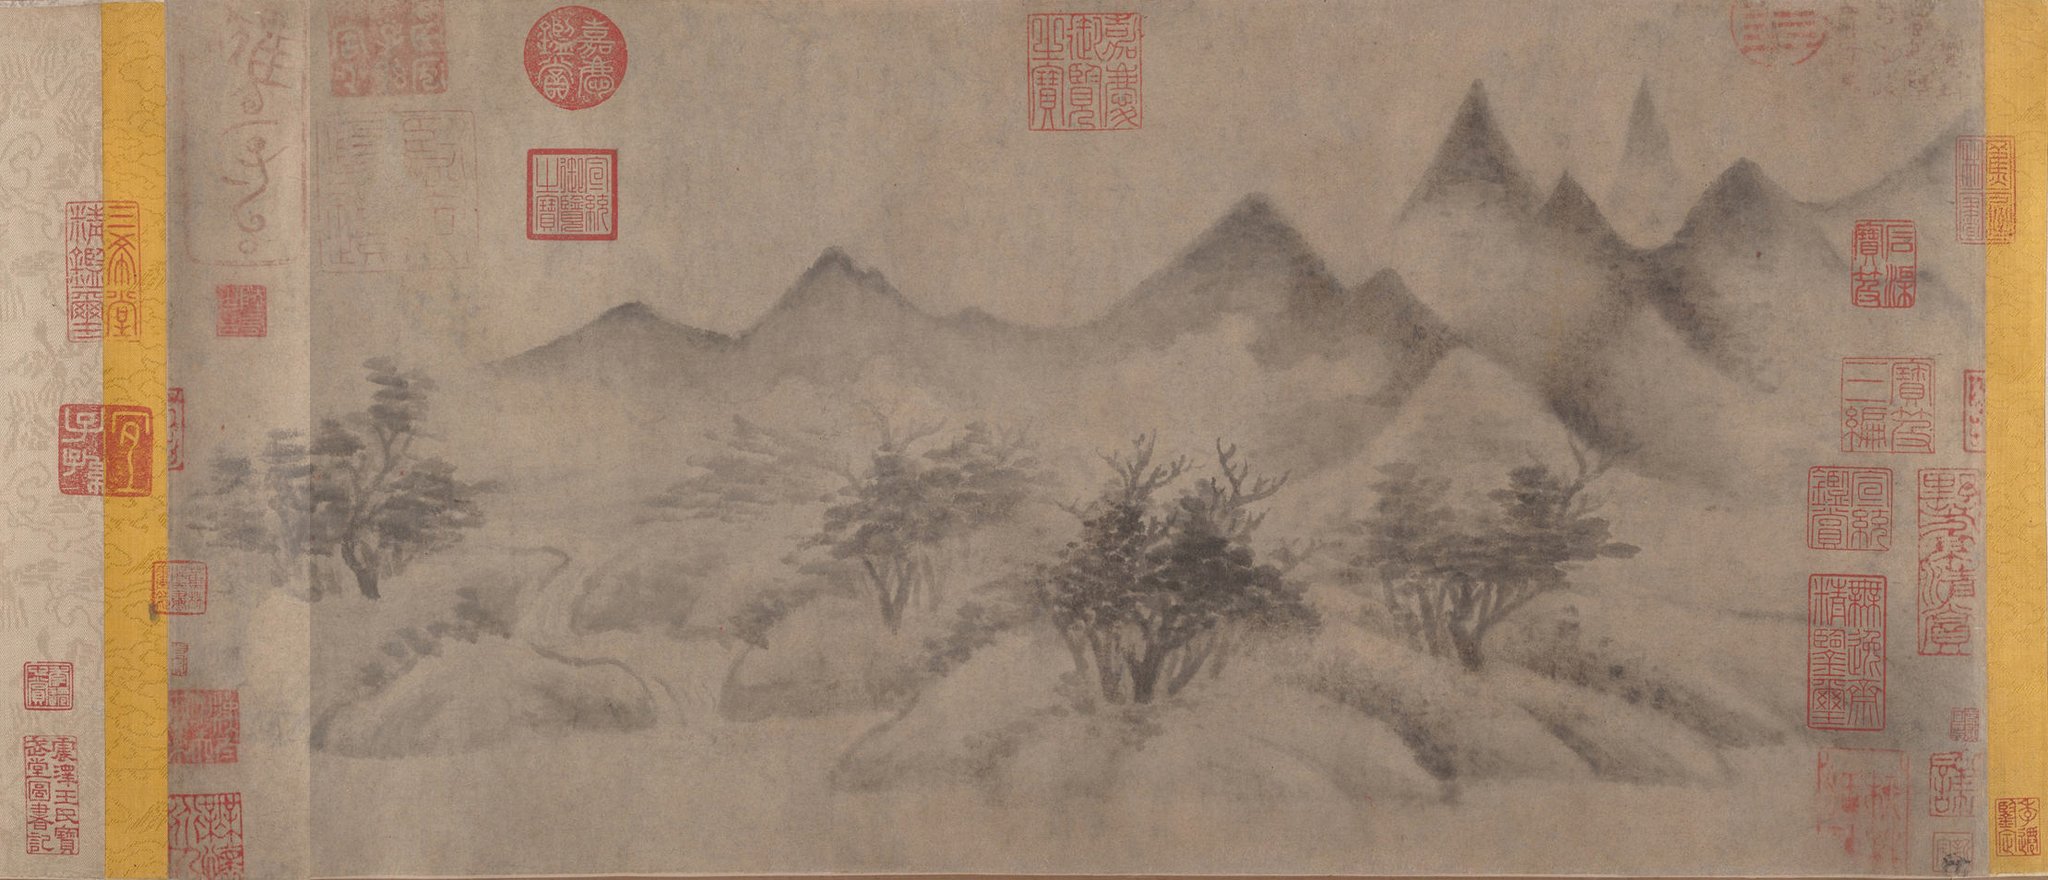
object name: handscroll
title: Cloudy Mountains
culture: chinese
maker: mi youren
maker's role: artist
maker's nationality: chinese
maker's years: 1074-1151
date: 1200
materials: ink, paper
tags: mountains,landscapes